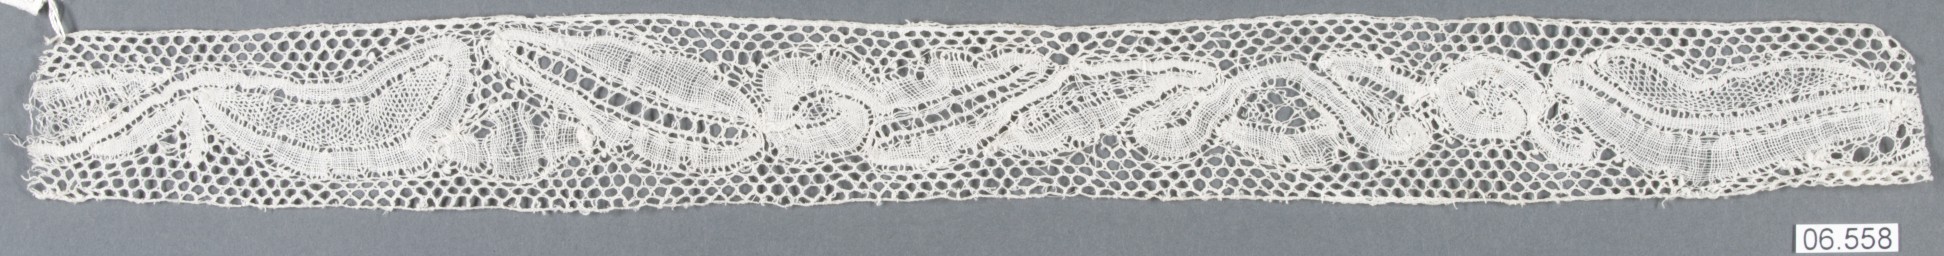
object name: strip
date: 1801-1900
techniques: lace